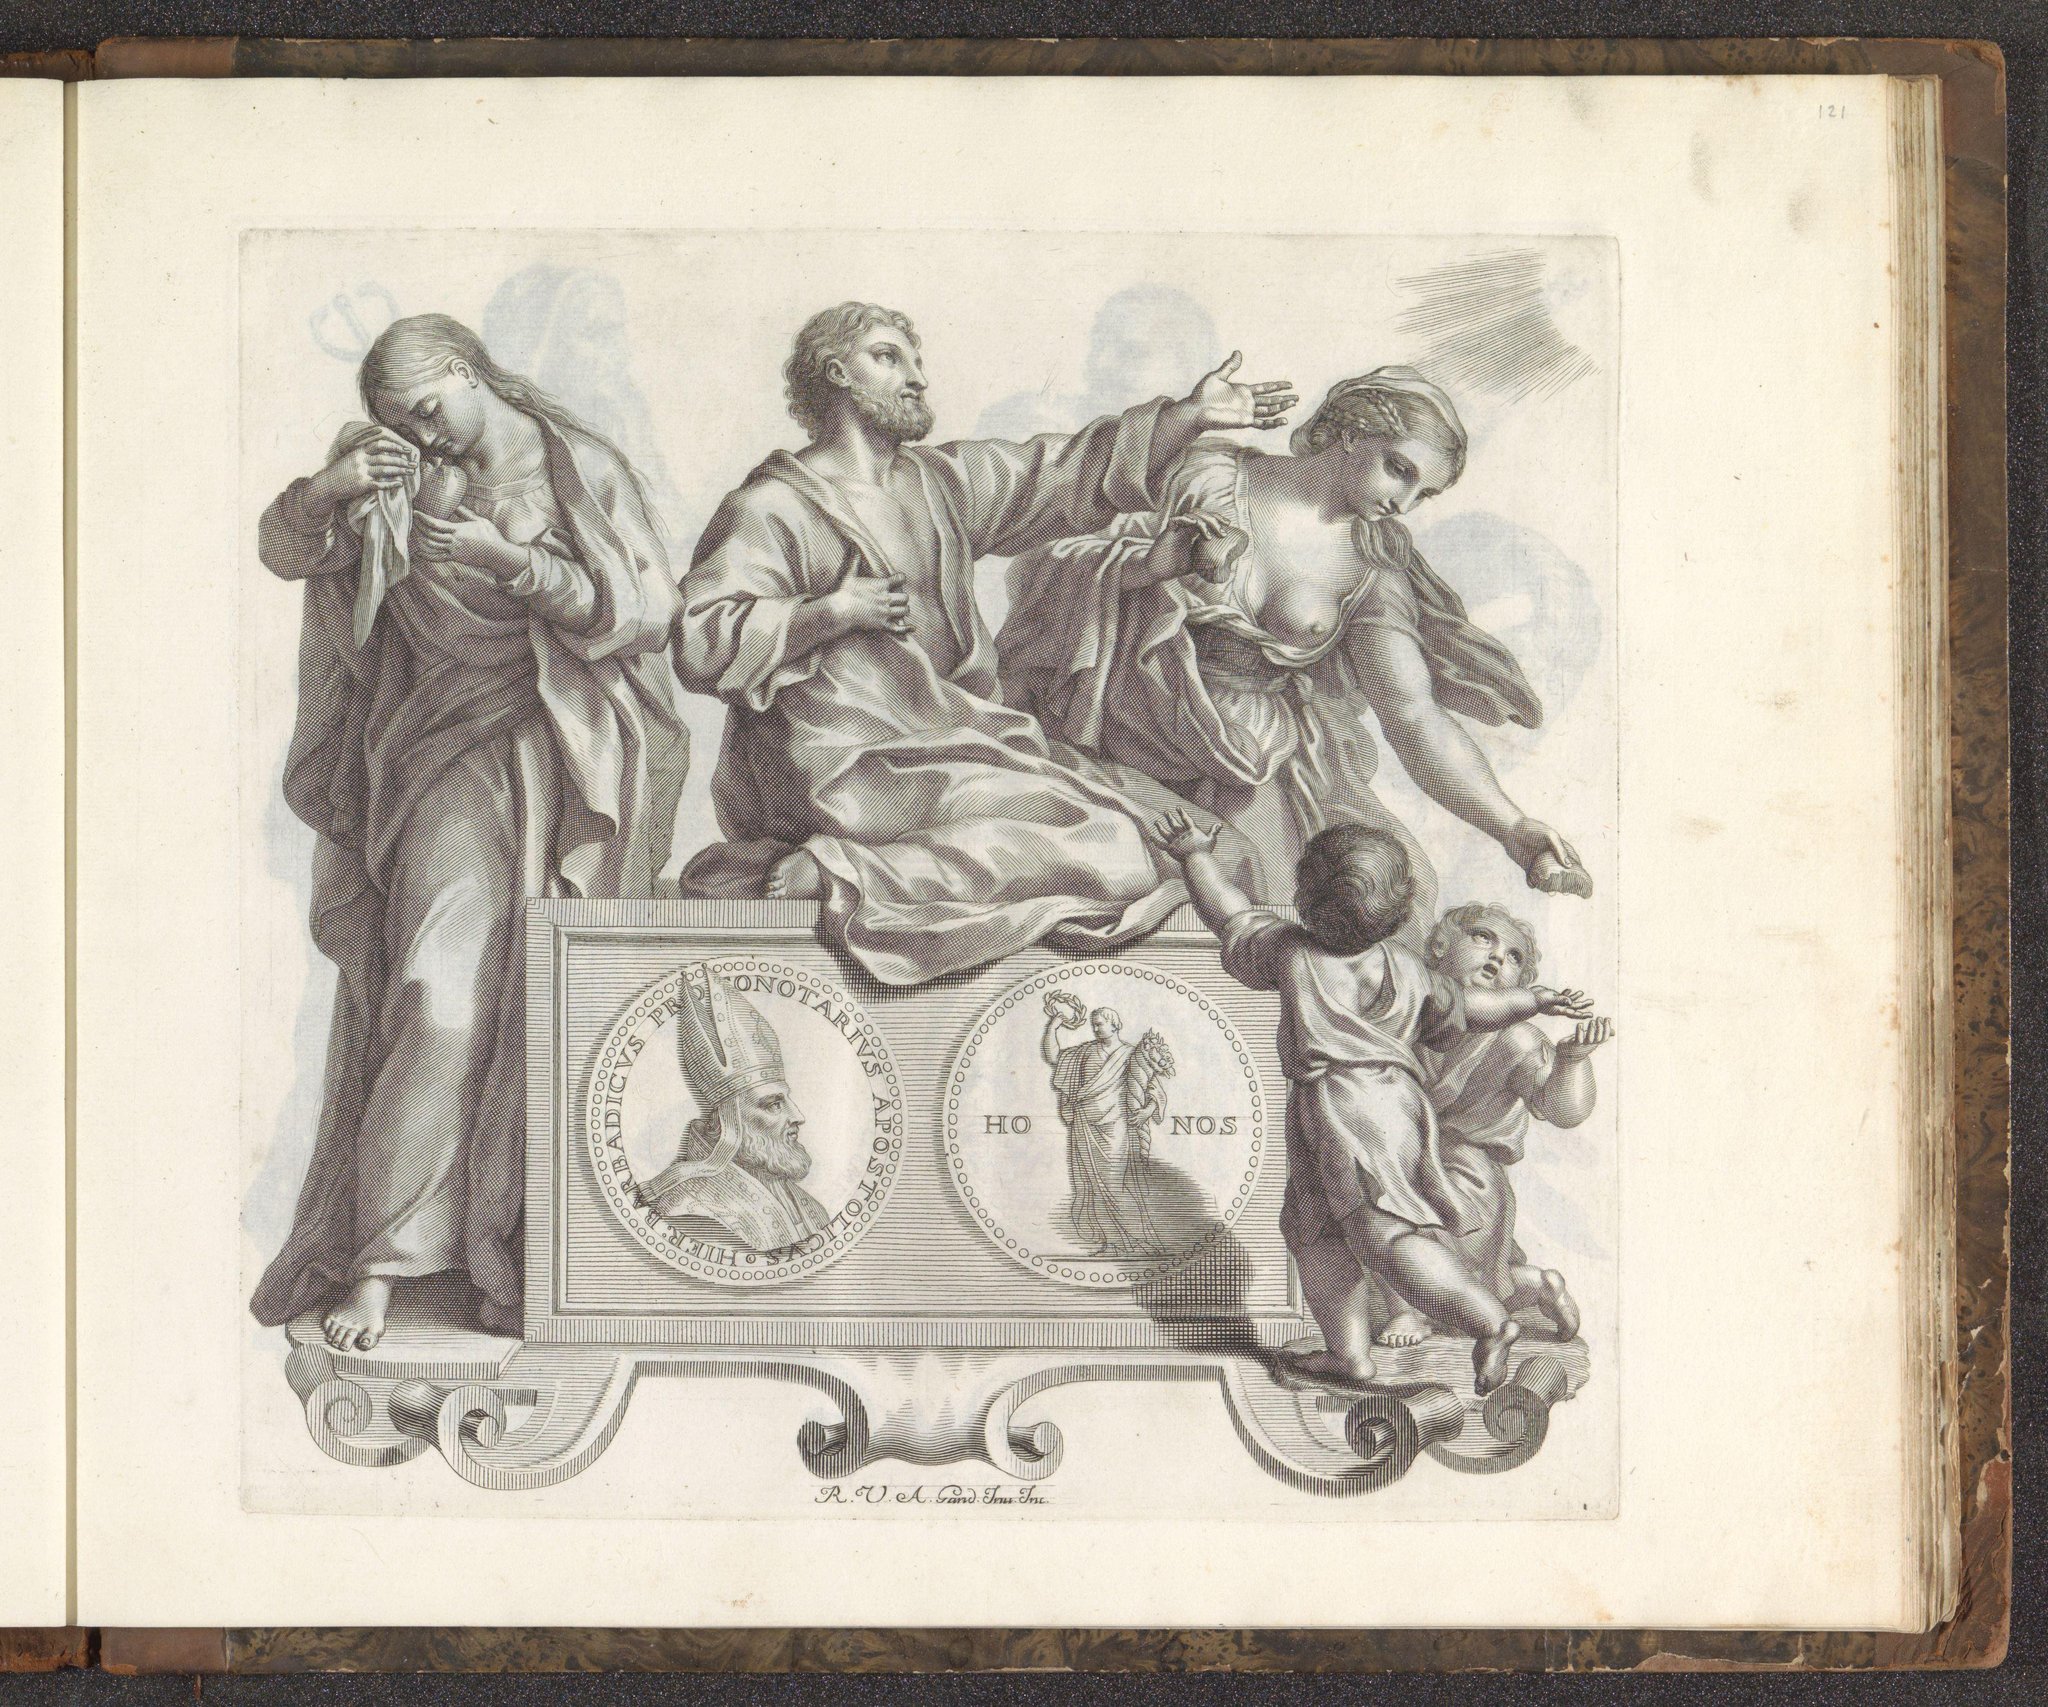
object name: print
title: Portret van Girolamo Barbarigo met de personificaties van drie Zaligheden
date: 1673-1743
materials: paper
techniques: engraving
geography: rome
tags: 'beatitudine prima', 'povertà di spirito' (ripa), 'beatitudine quinta' (ripa), 'beatitudine sesta' (ripa), medal (considered as a piece of sculpture, regardless of its specific function), honour, glory; 'ampiezza della gloria', 'gloria', 'gloria de prencipi', 'gloria & honore', 'honore', 'sublimatà della gloria' (ripa), mercy, compassion; 'compassione', 'misericordia' (ripa)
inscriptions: collector's mark: Lugt 2228